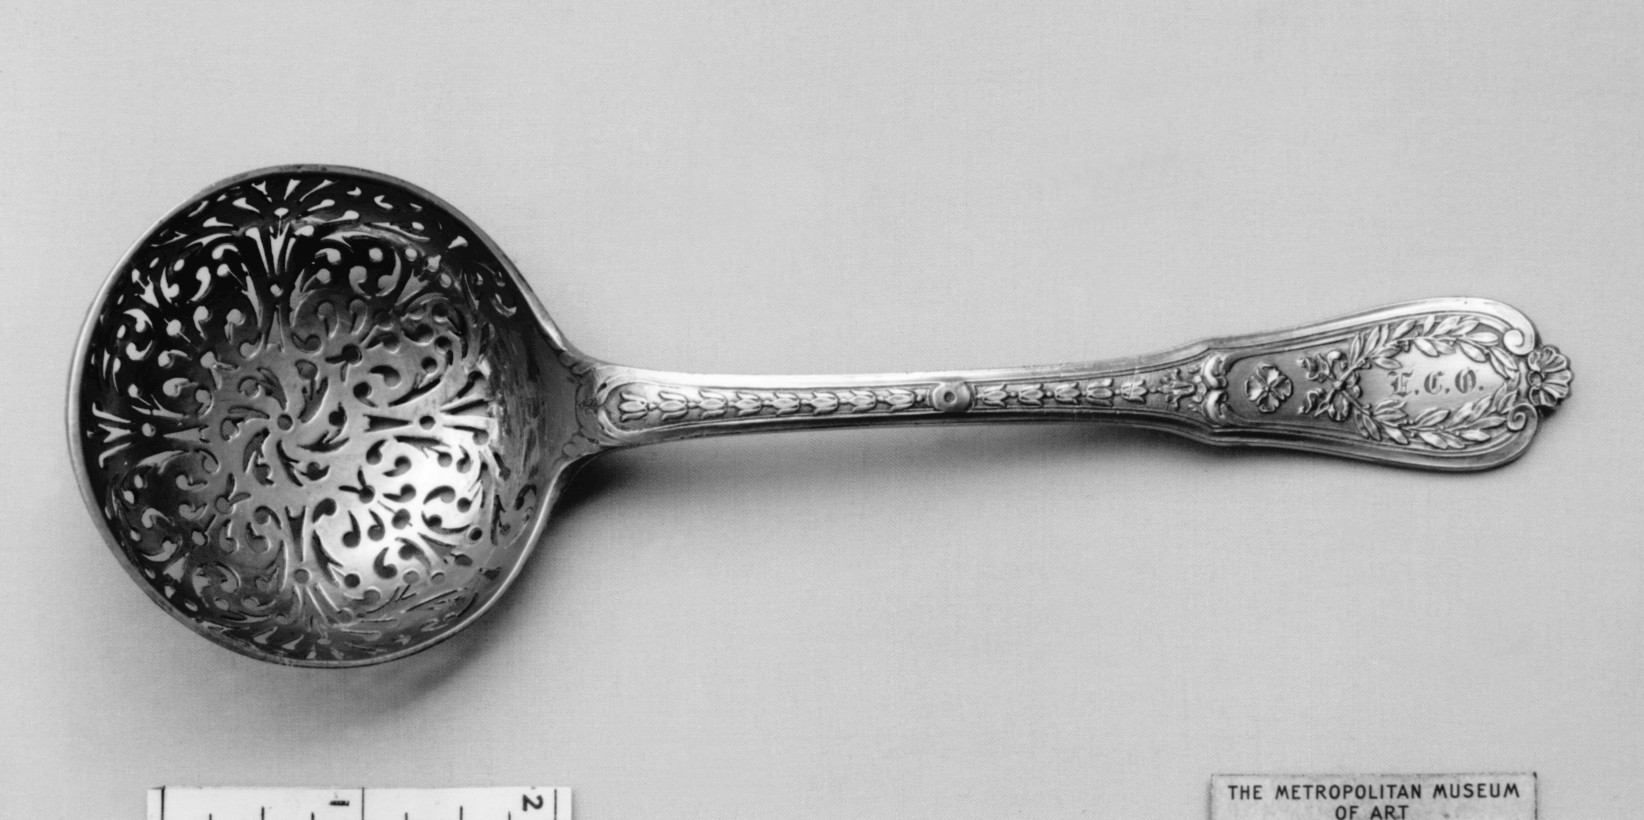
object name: sugar spoon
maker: claude-auguste aubry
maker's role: maker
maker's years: 1728-1791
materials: silver gilt